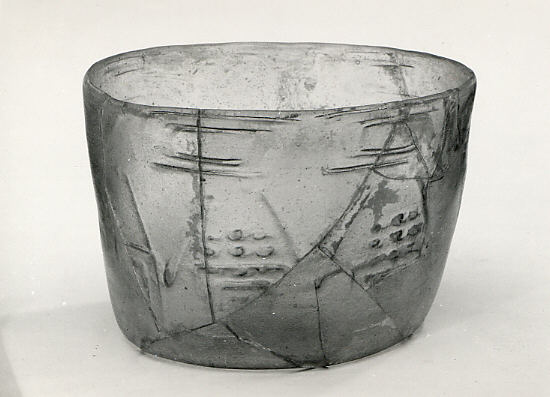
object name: fragment of a bowl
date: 801-1000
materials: glass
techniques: cutting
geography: iran